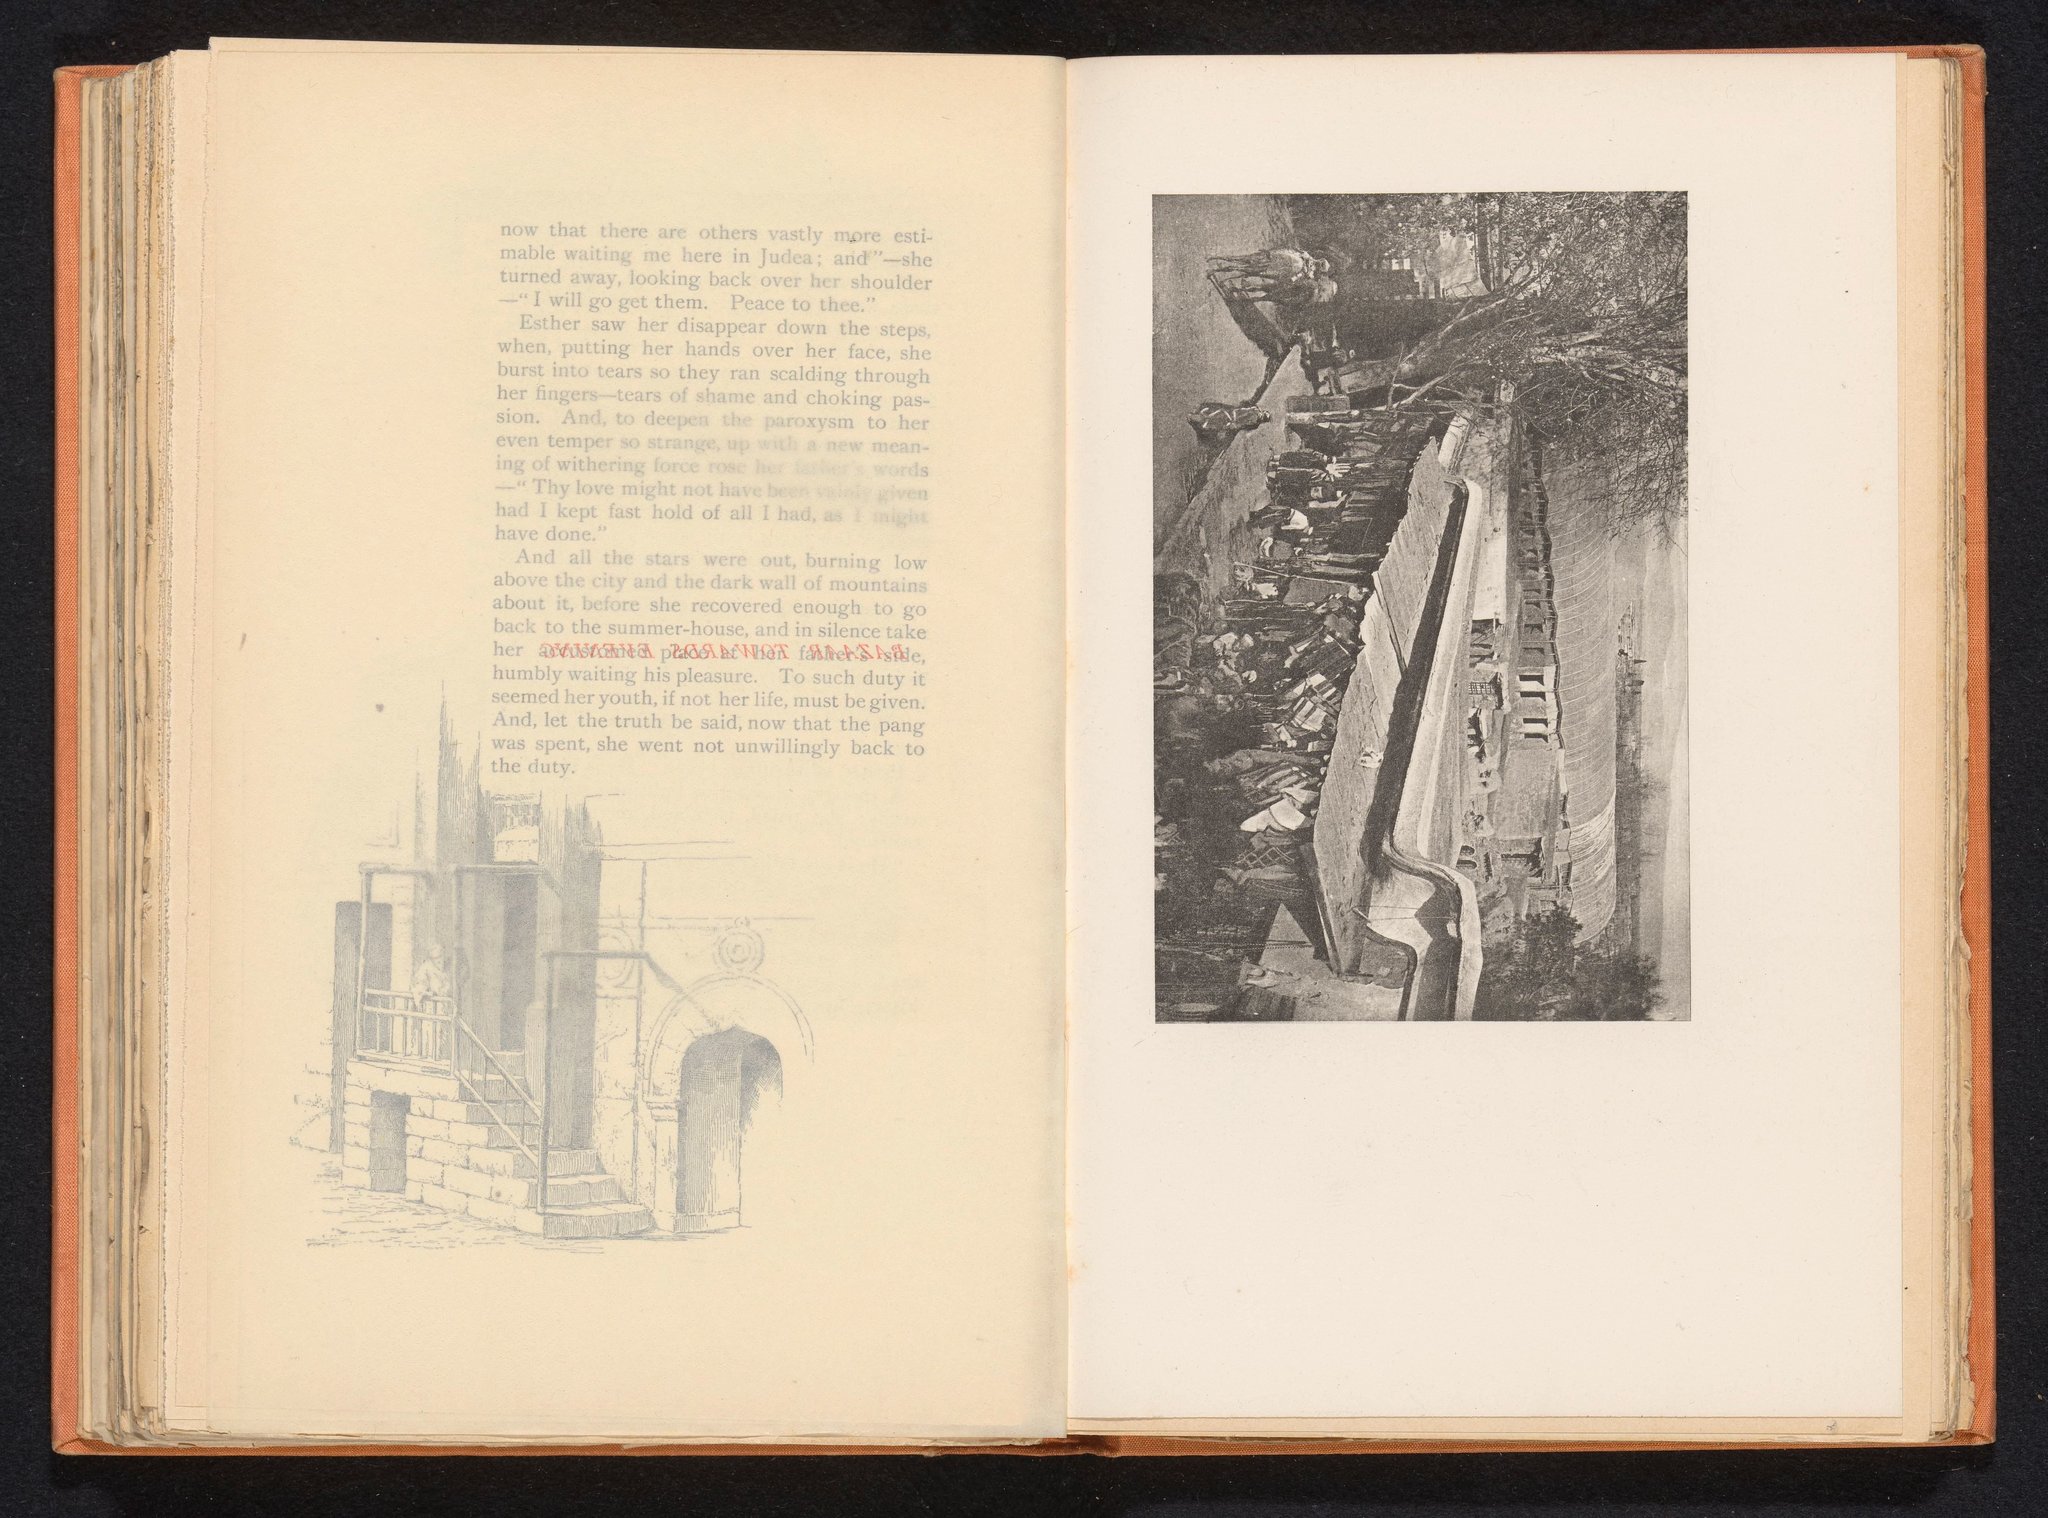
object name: page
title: Gezicht op een bazaar in vermoedelijk Israël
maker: Anonymous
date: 1882-1892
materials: paper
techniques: photoaquatint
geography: israel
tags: market-hall